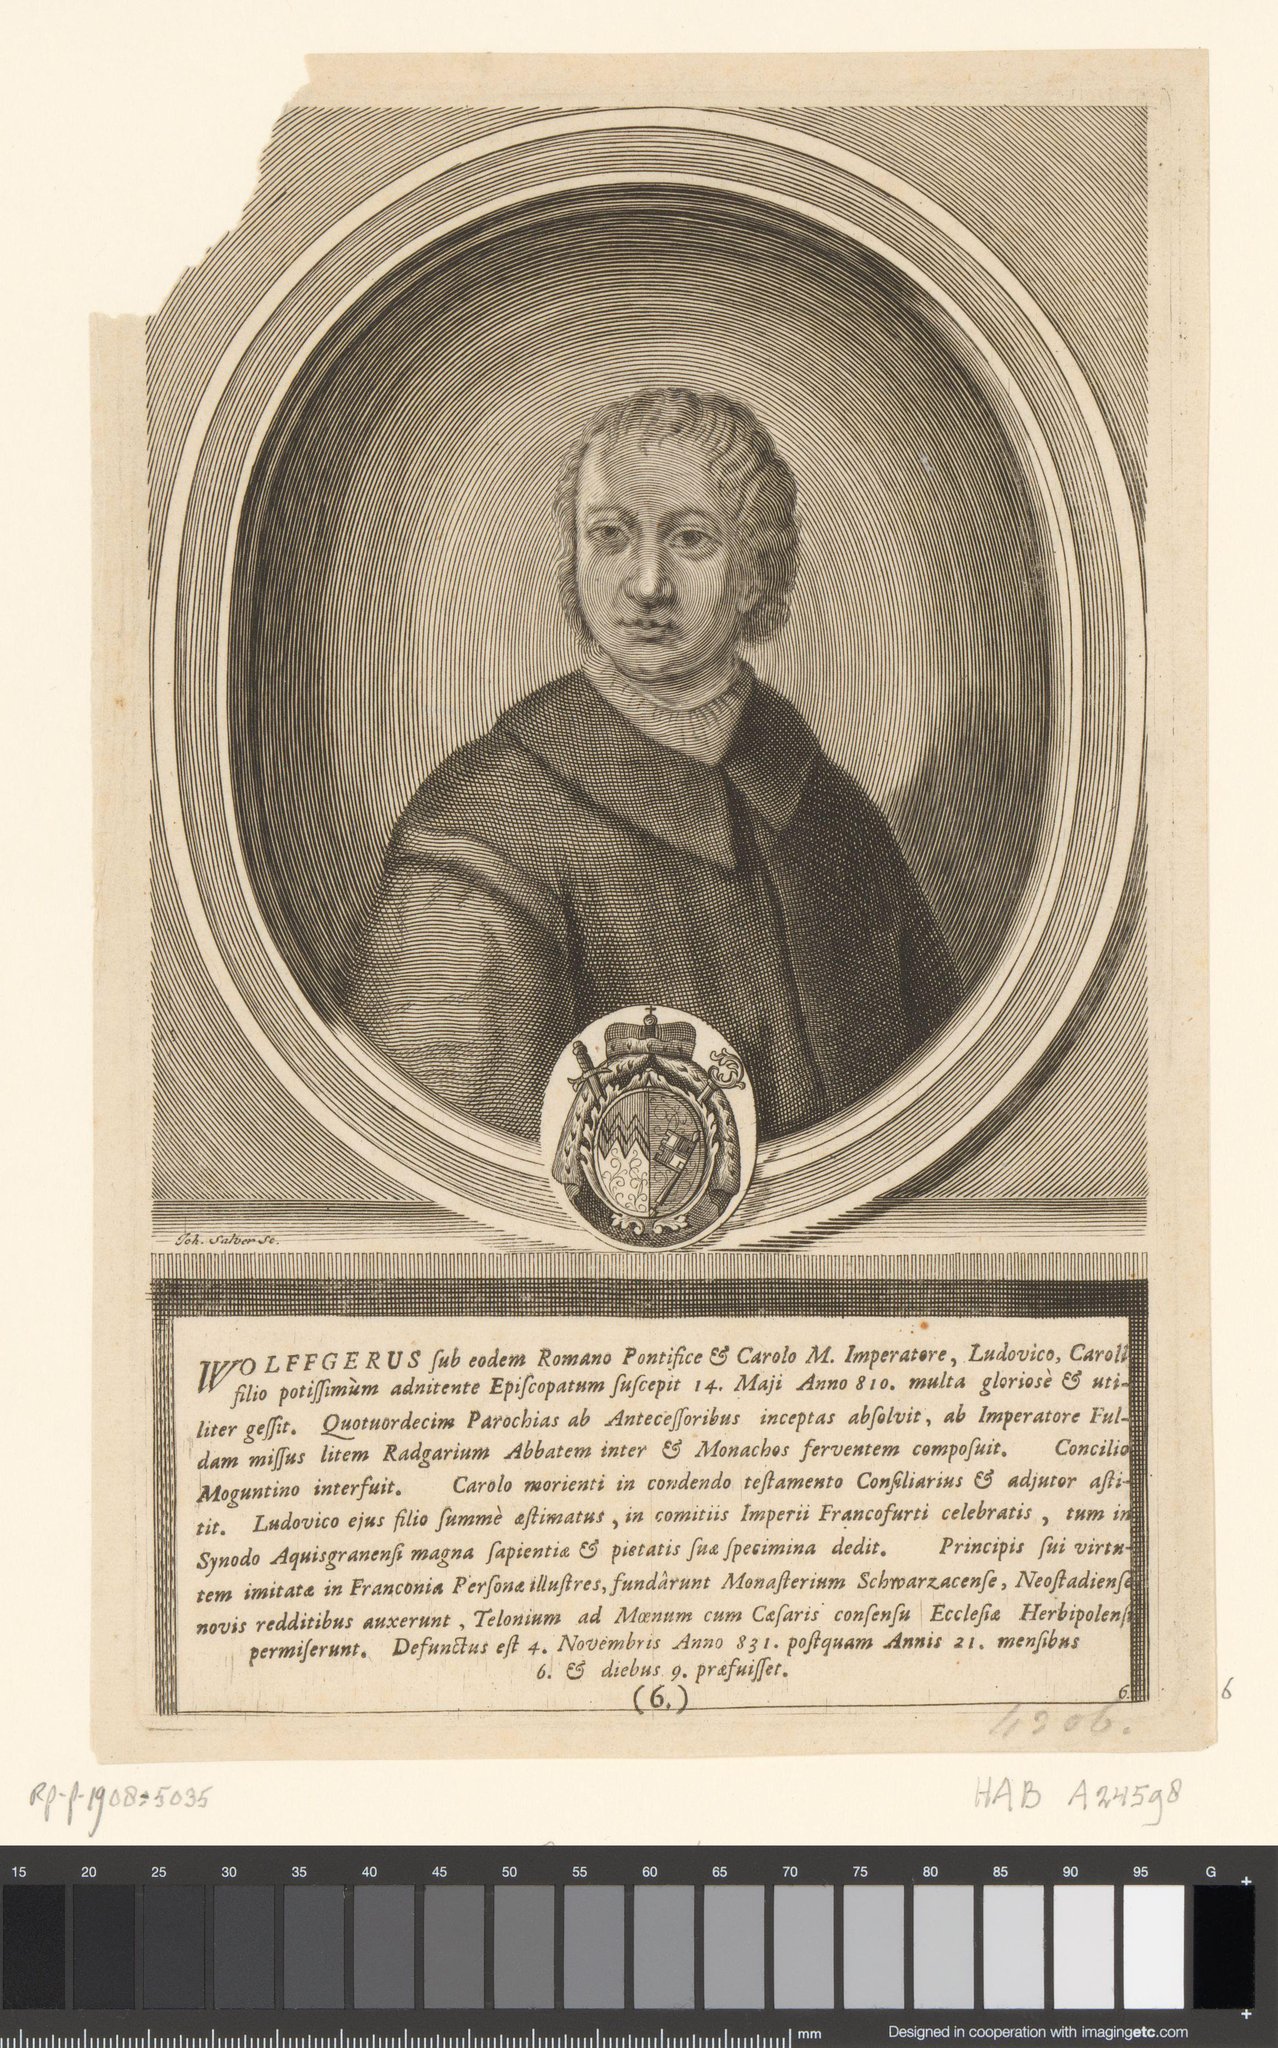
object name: print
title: Portret van Wolfger van Würzburg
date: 1713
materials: paper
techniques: engraving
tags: archbishop, bishop, etc. (roman catholic), theologian, historical persons, armorial bearing, heraldry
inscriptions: collector's mark: Lugt 2228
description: Prent ook gebruikt in: Ludewig, Johann Peter von. Geschicht-Schreiber von dem Bischoffthum Wirtzburg. Frankfurt am Main: Thomas Fritsch, 1713.